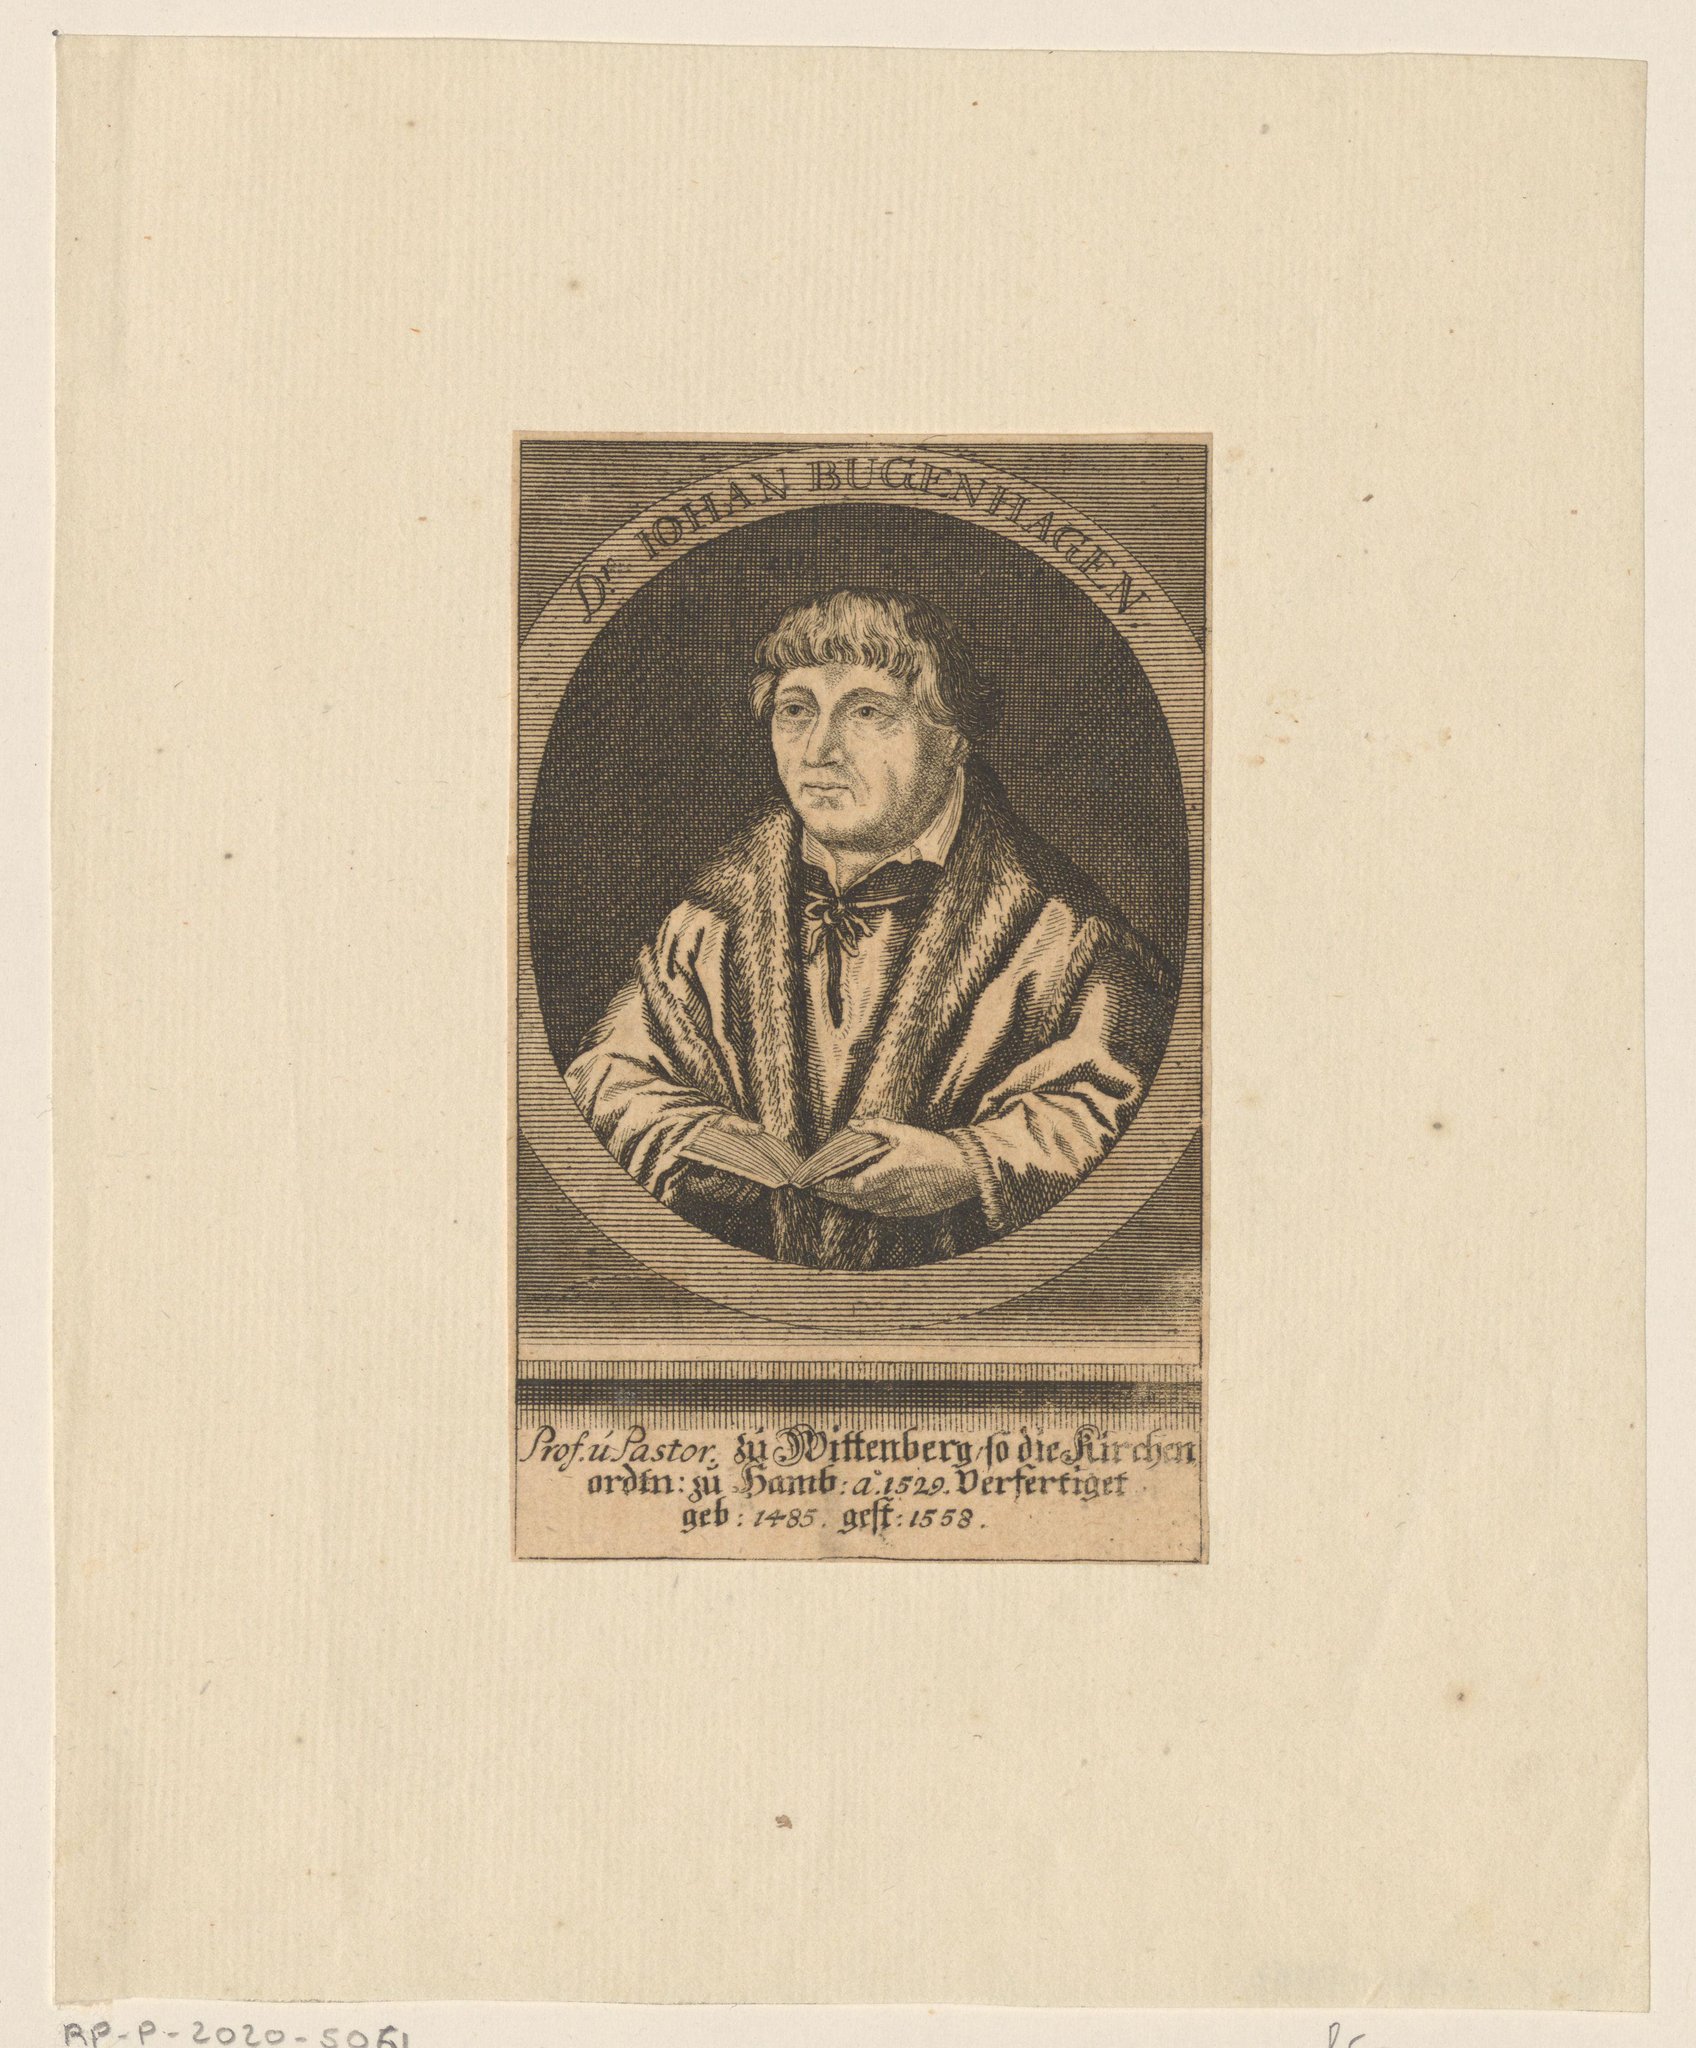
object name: print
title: Portret van Johann Bugenhagen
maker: Anonymous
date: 1650-1749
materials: paper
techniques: engraving, etching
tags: paris, theologian, historical persons, book